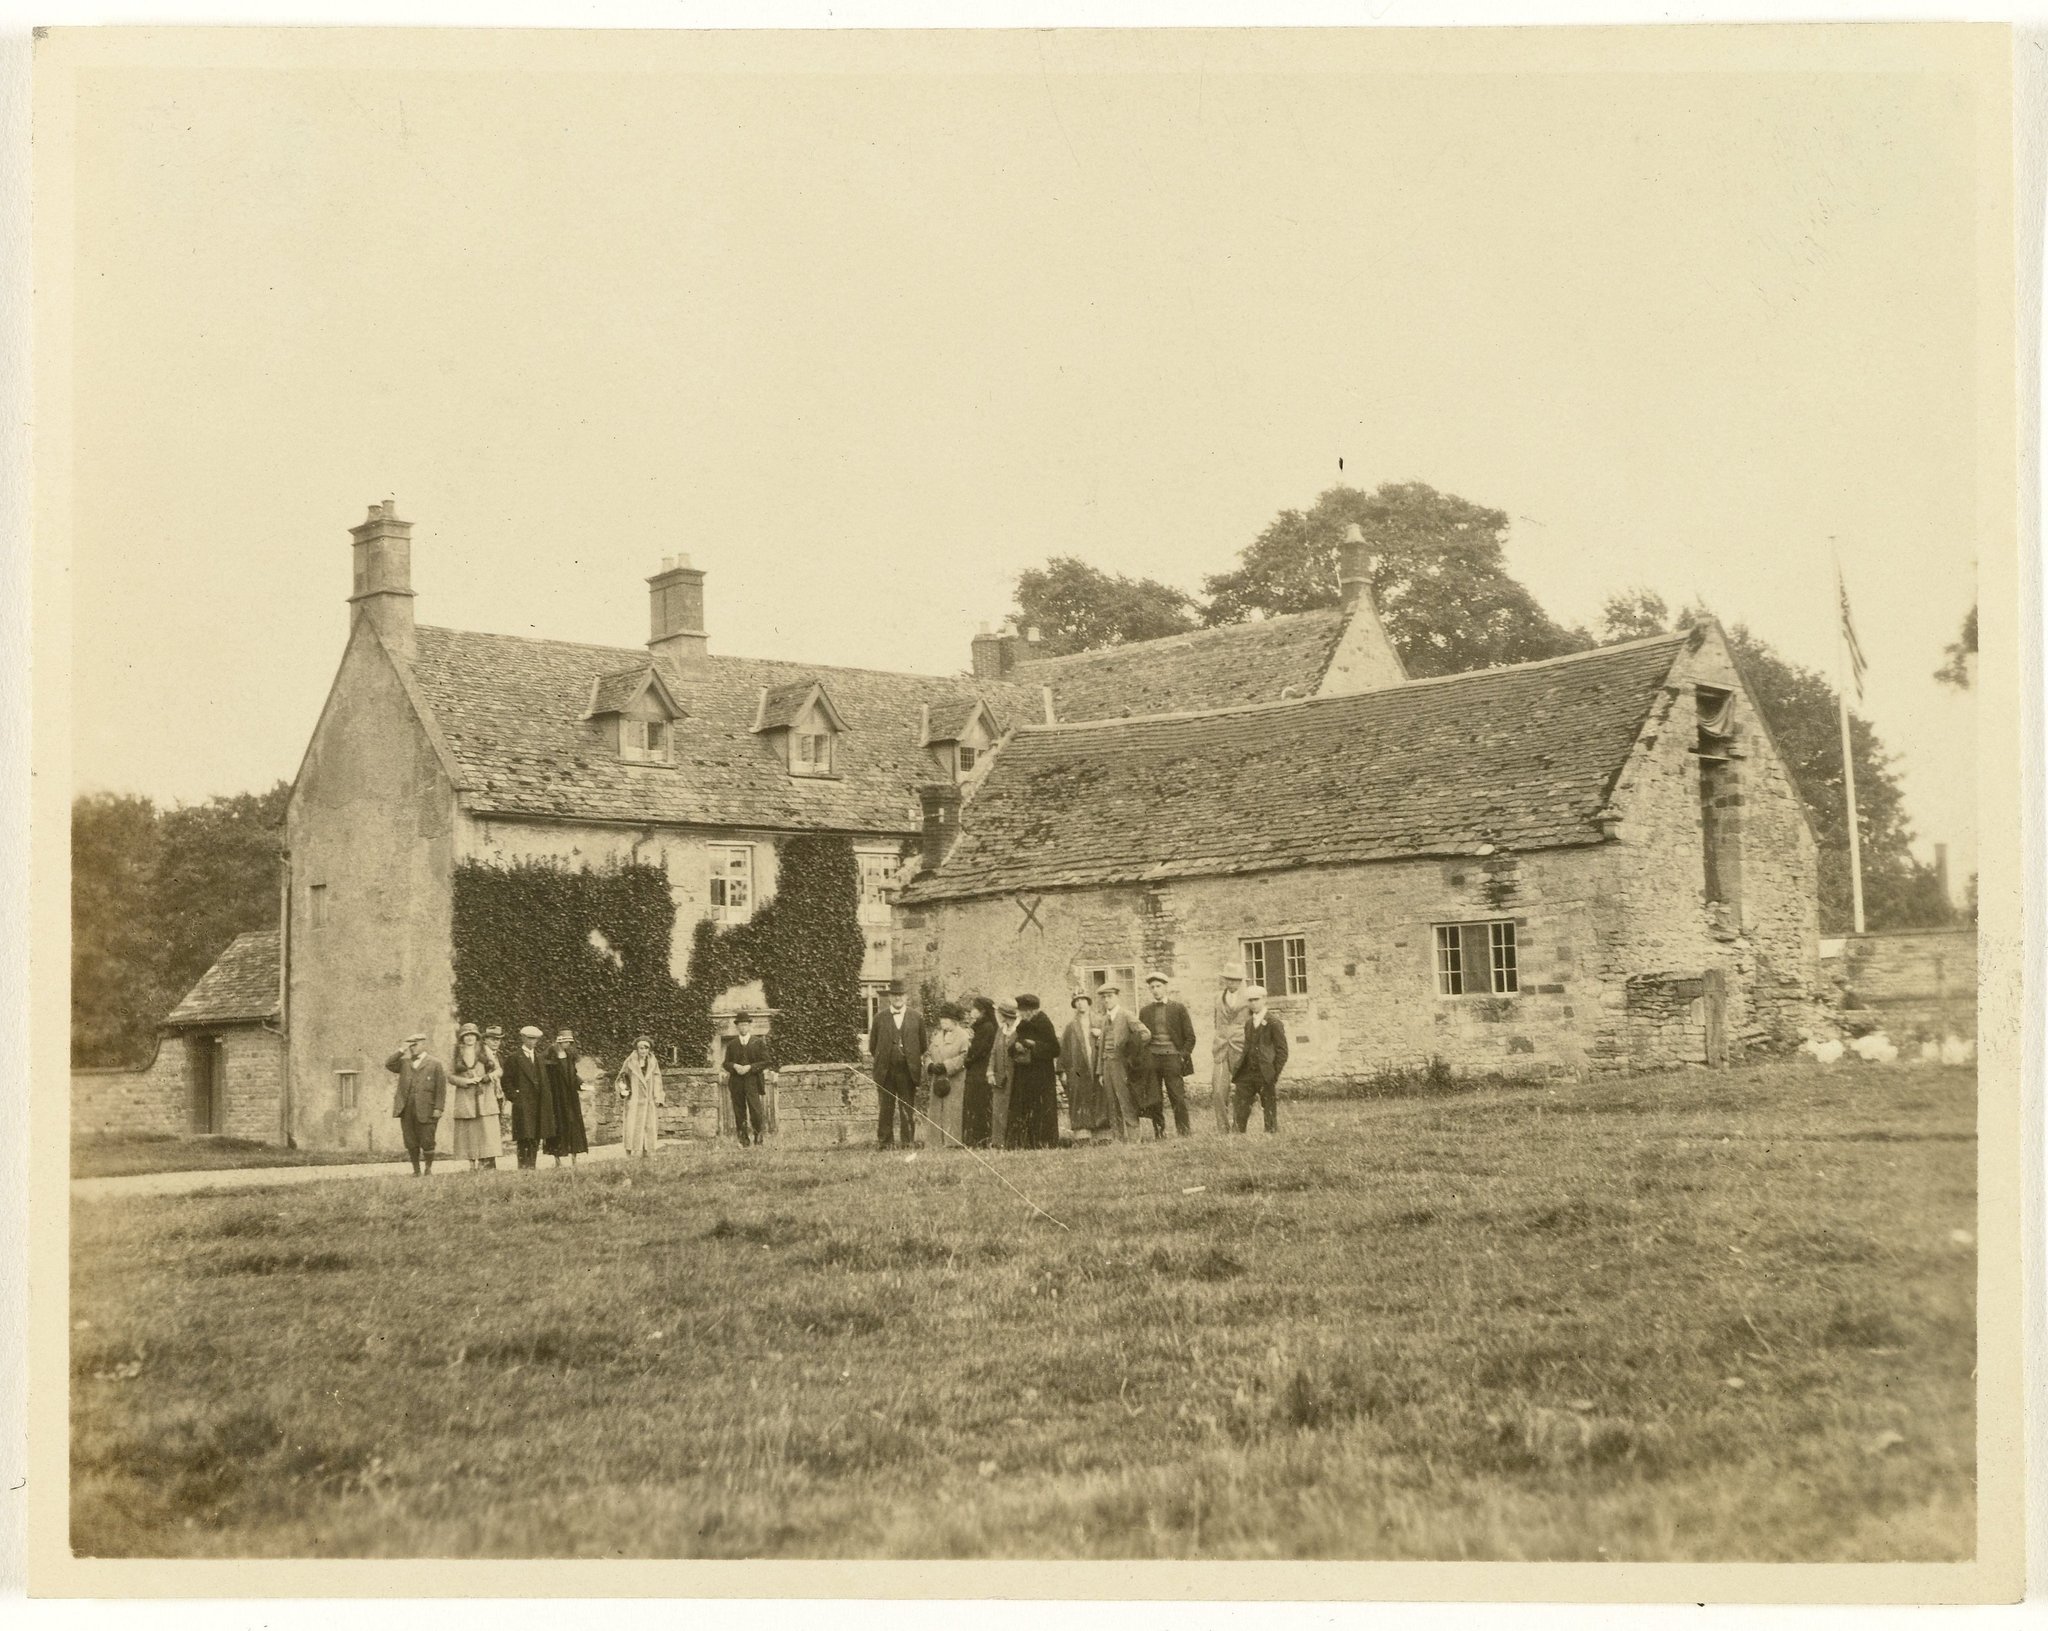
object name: photograph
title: Groep Amerikaanse toeristen bij een huis met een Amerikaanse vlag (Engeland?)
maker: Anonymous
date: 1921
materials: paper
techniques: gelatin silver print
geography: england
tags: tourism, england